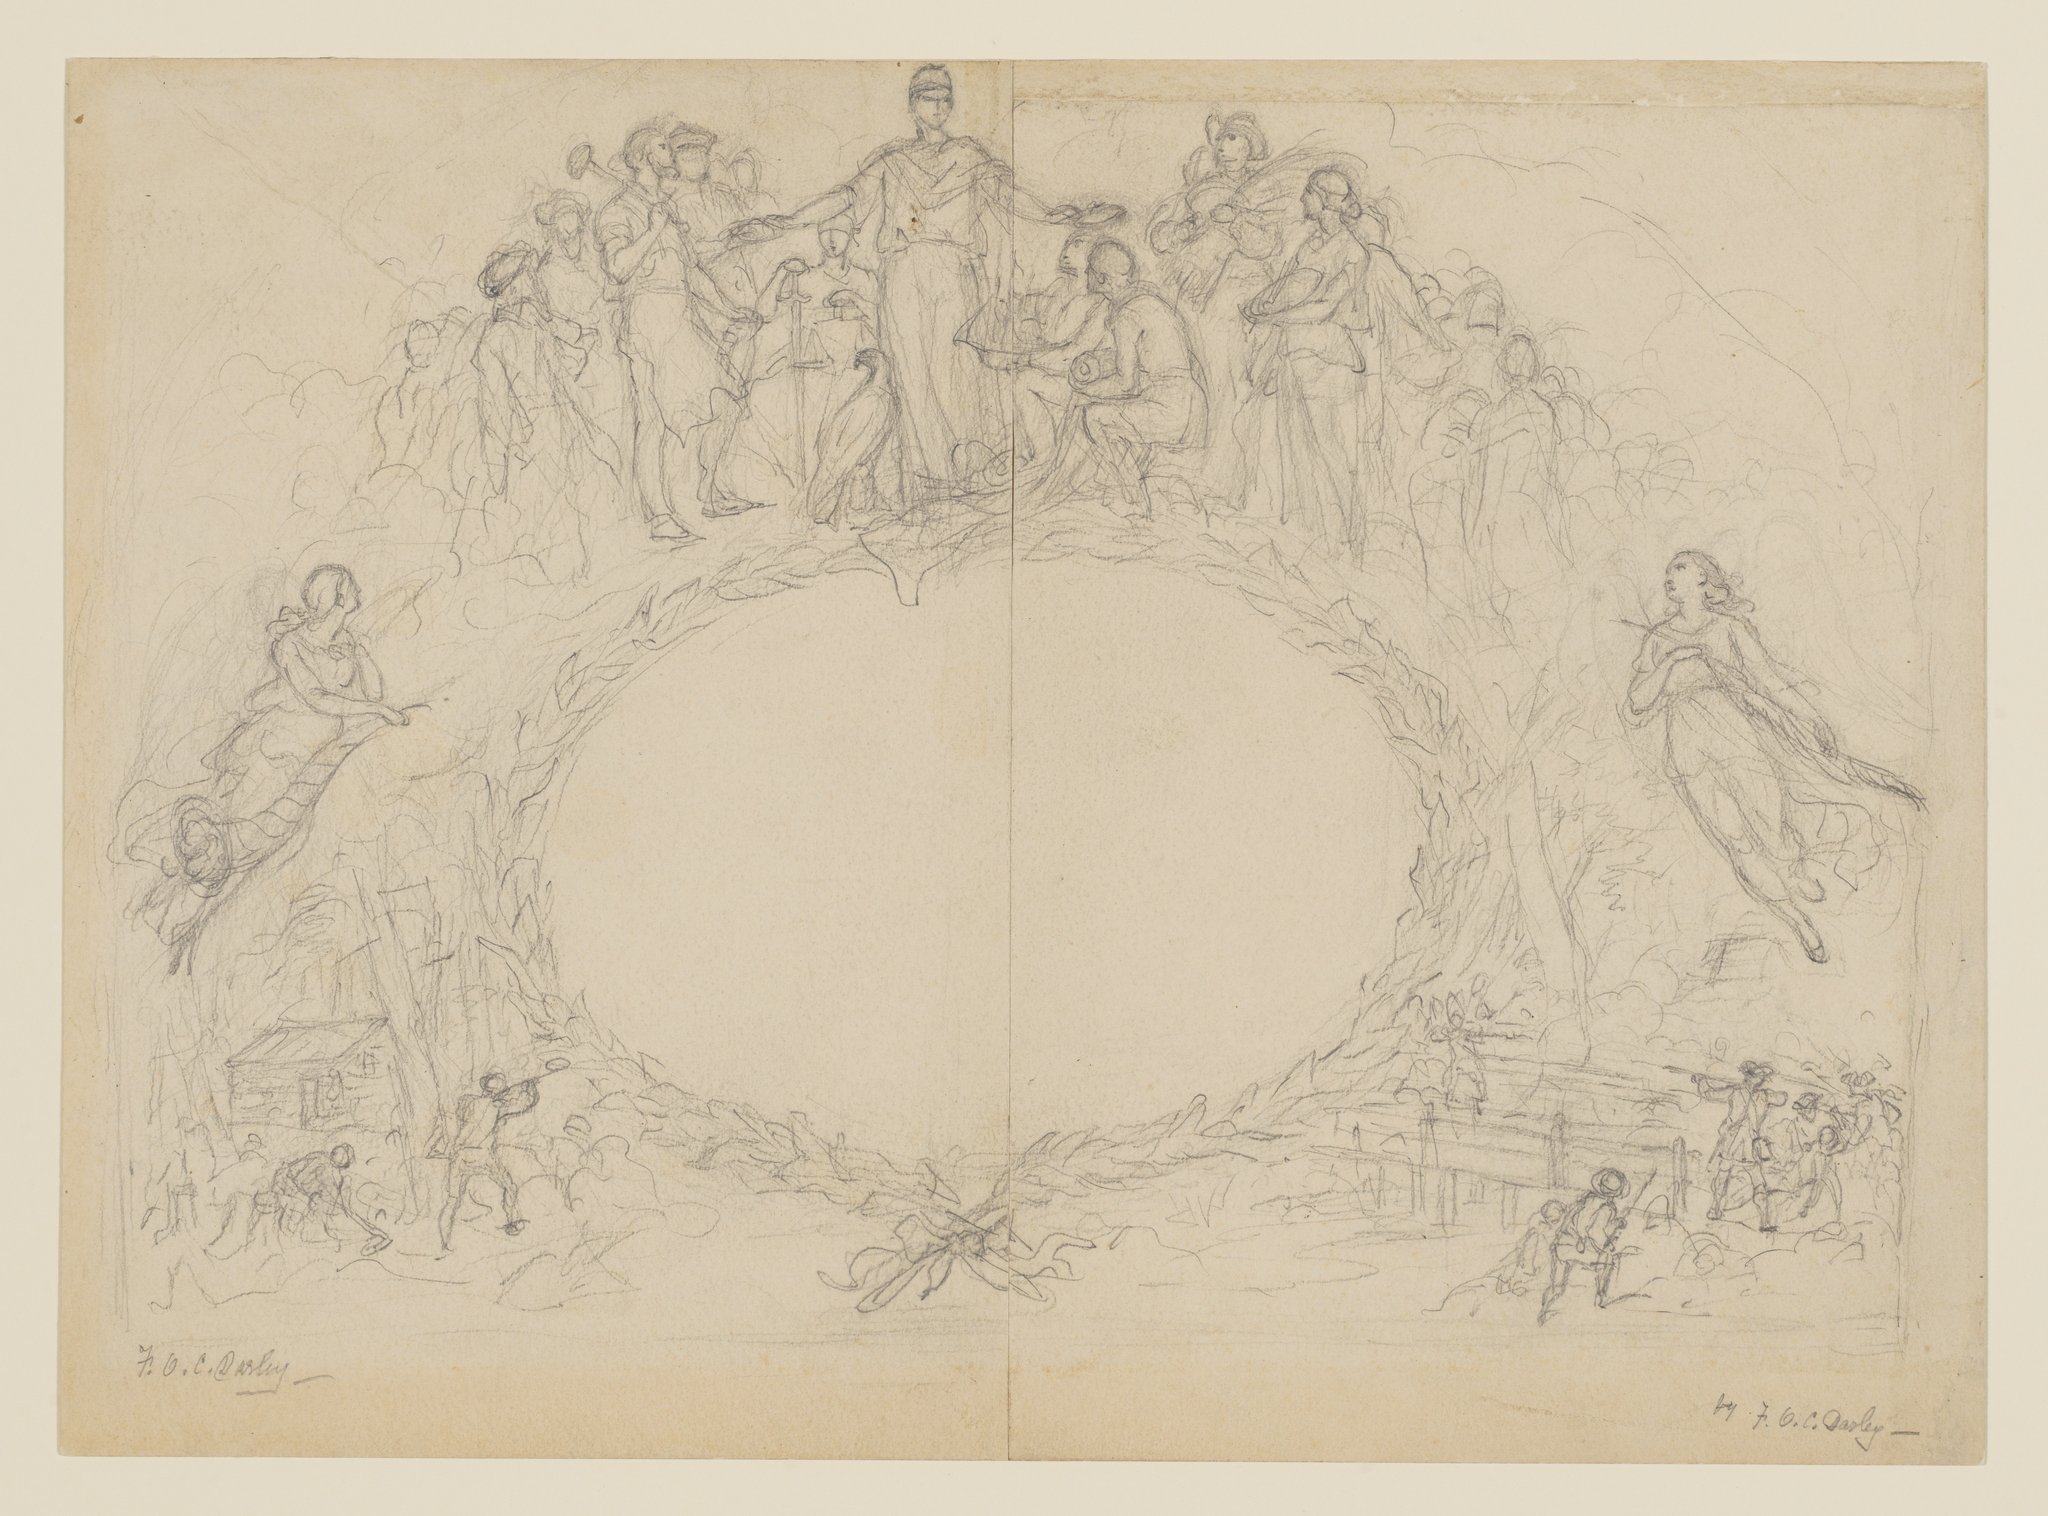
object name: drawing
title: Allegorical cartouche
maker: felix octavius carr darley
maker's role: artist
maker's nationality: american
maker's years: 1822-1888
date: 1842-1888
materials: graphite